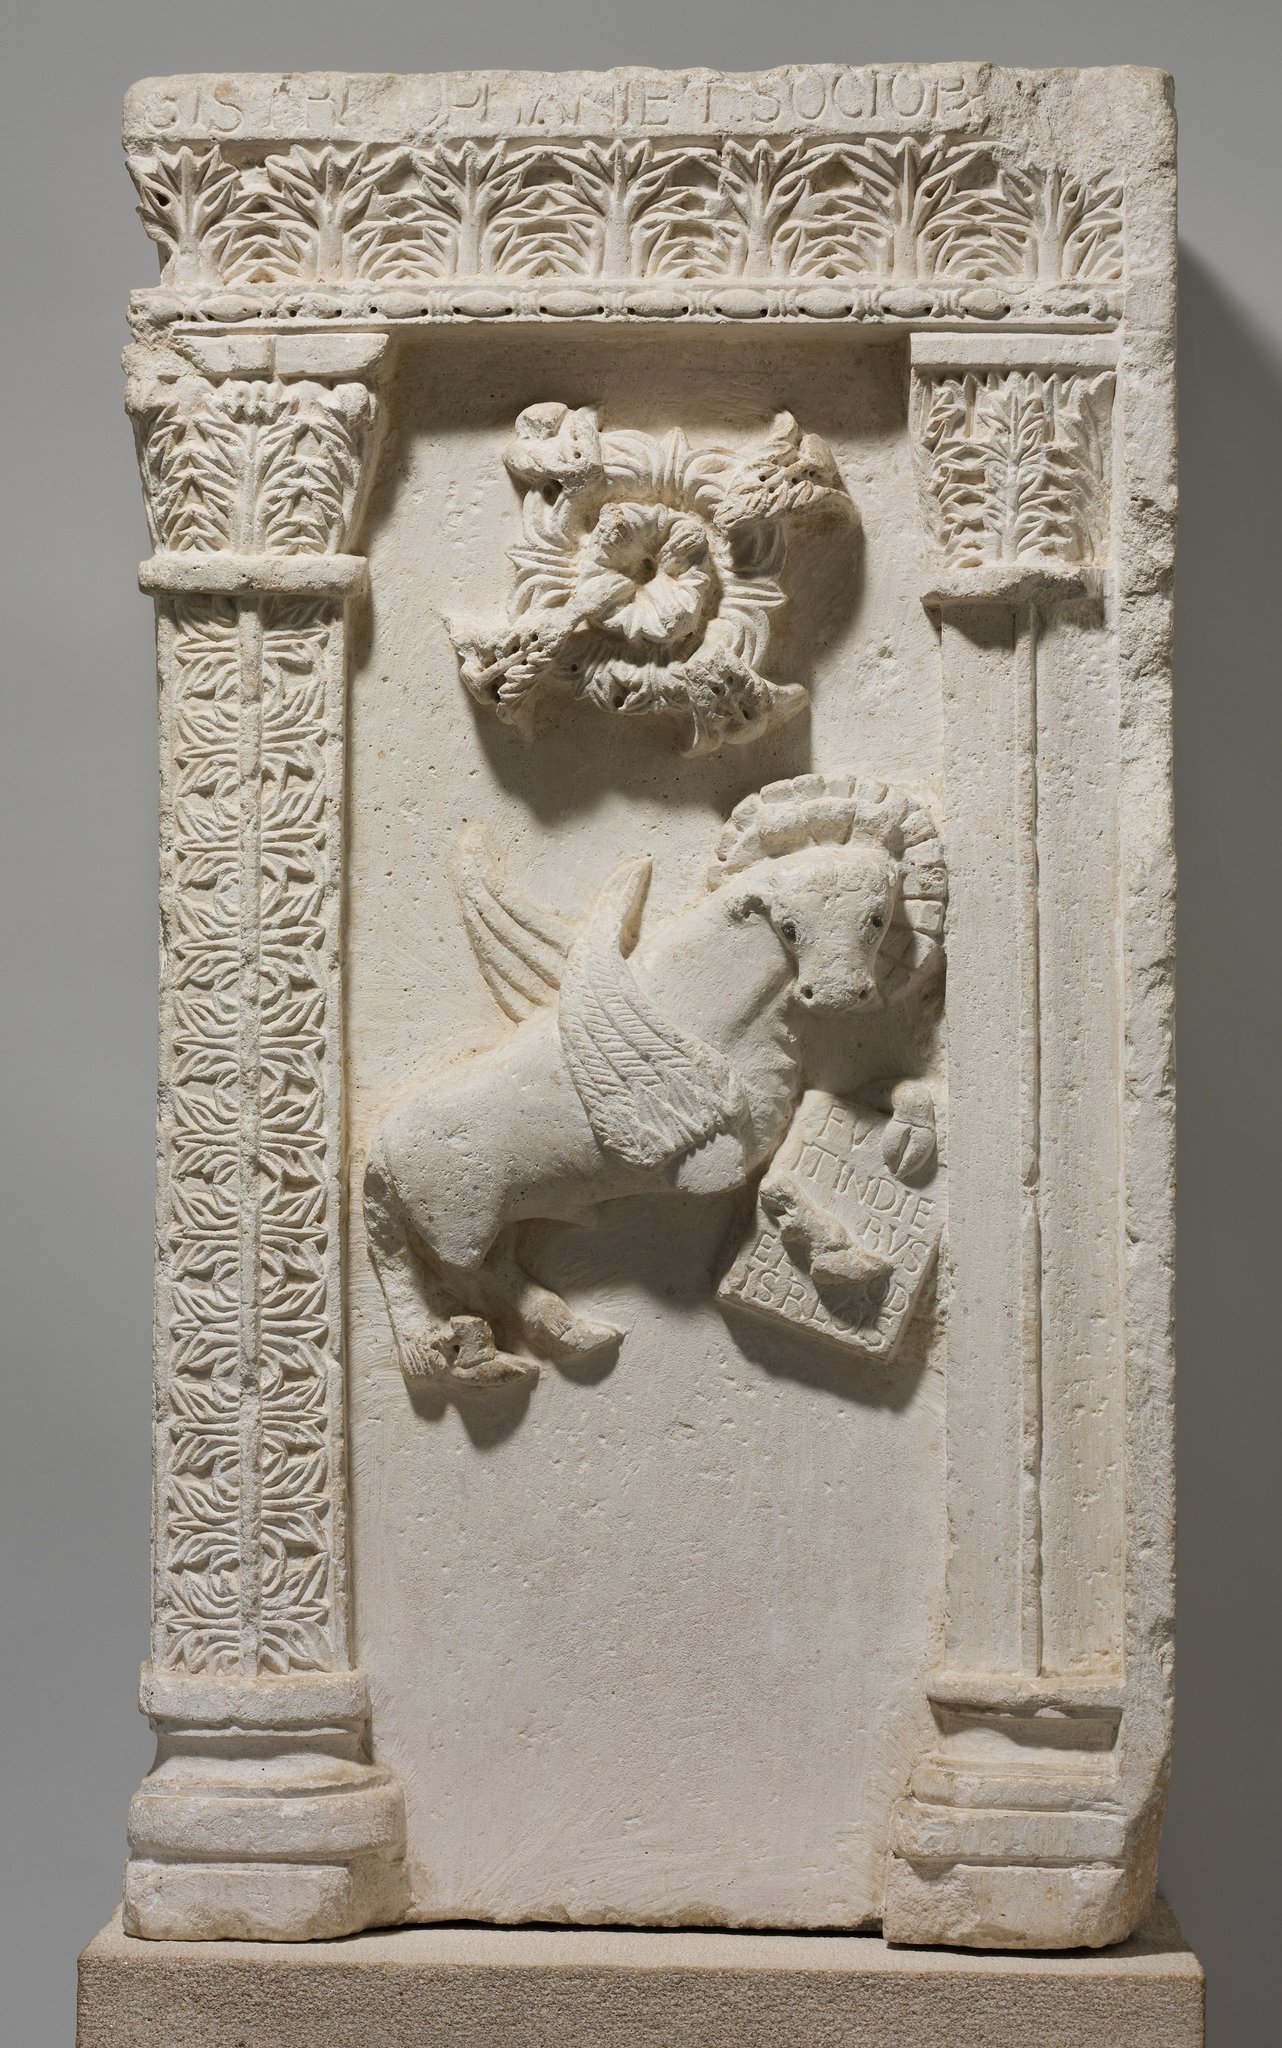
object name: relief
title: Relief from a Pulpit with the Symbol of Saint Luke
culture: italian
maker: master christophanus or stephanus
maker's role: artist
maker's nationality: italian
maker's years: 1171-1200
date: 1180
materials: lead, limestone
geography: central italy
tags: bulls,saint luke